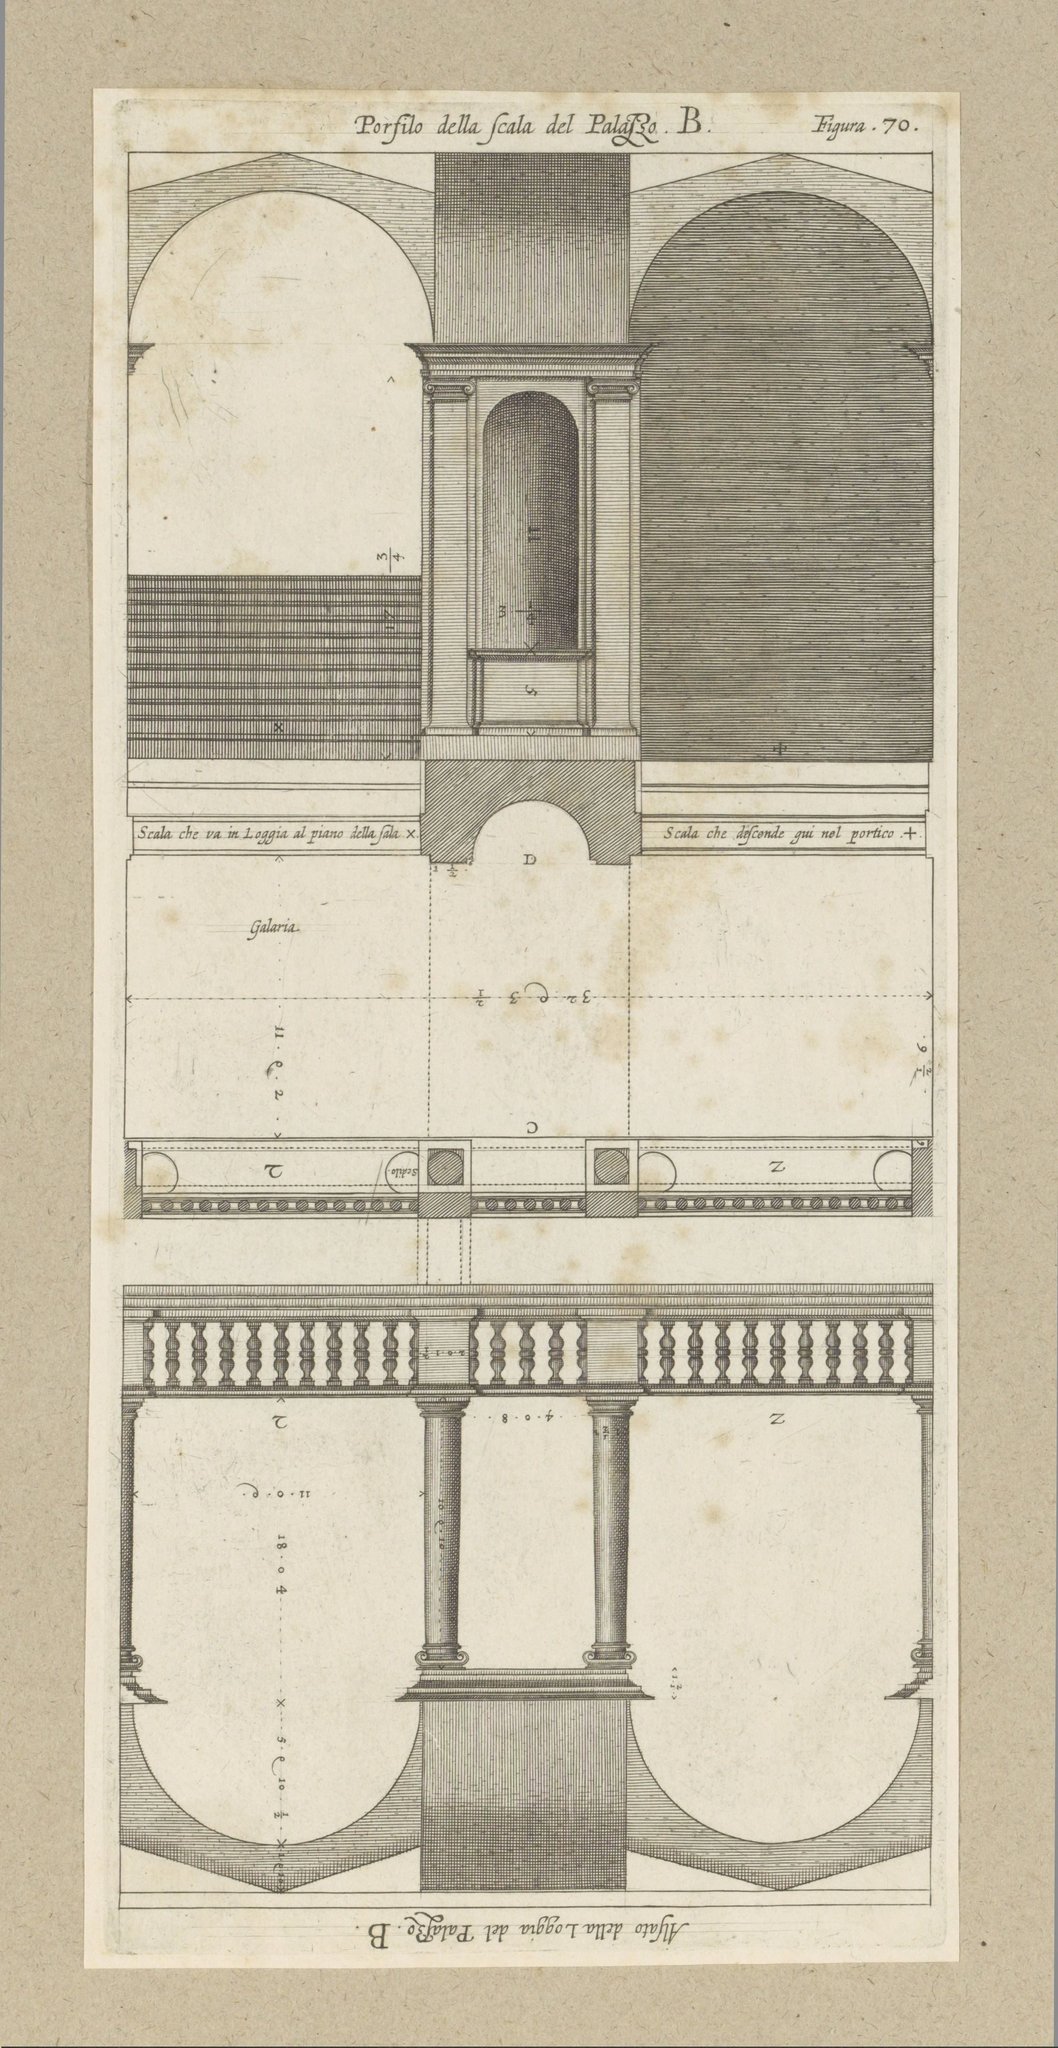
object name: print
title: Pianta del porticho del Palazzo / del Sigr. Don Carlo Doria / Pianta del porticho del Palazzo / dil sigr. Augustino Pallavicino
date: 1622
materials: paper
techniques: engraving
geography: antwerp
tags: vestibule, hall, hôtel, i.e. small palace in city, plan ~ architecture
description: Deze prent maakt deel uit van een album.